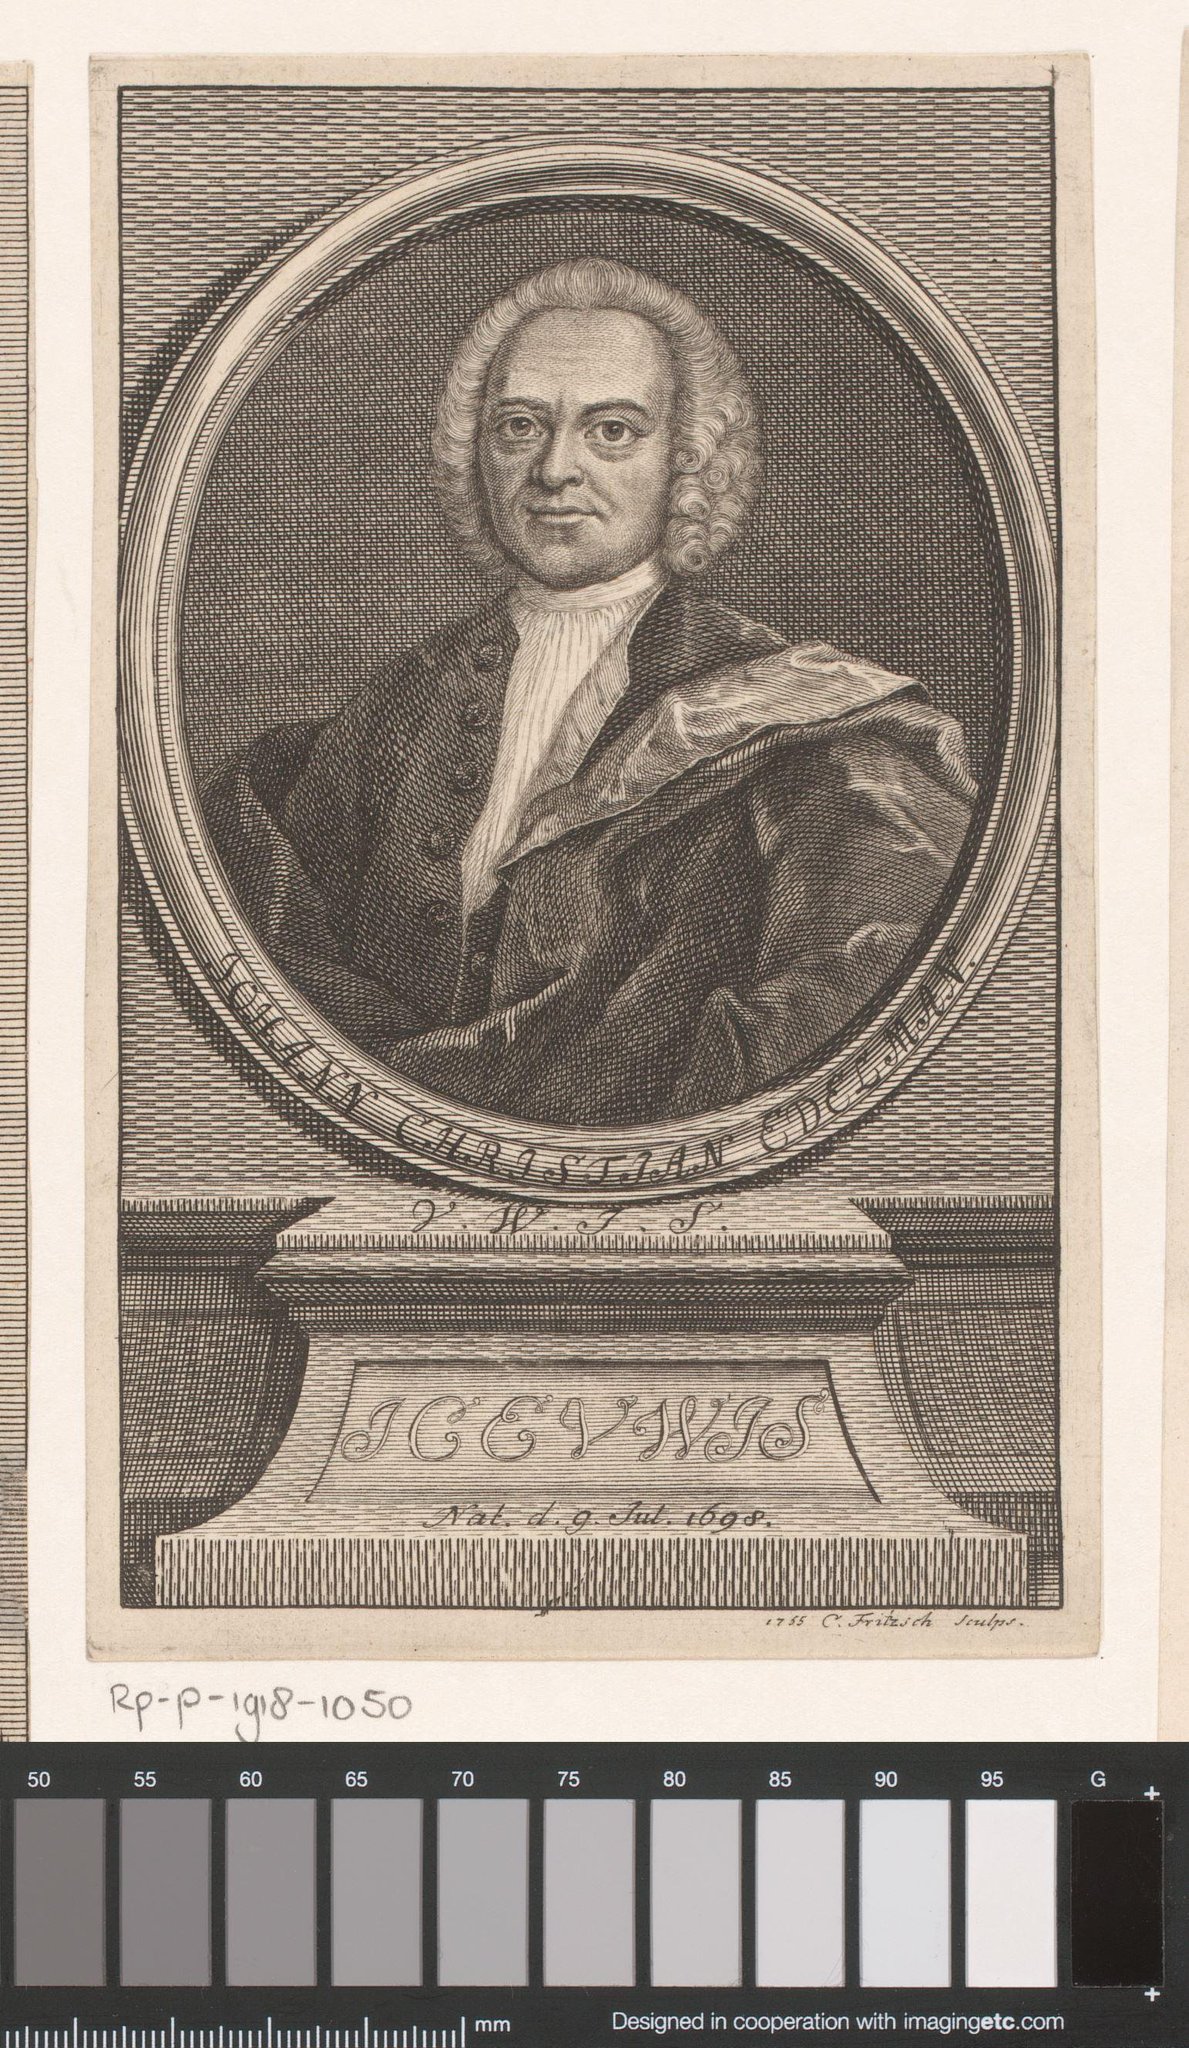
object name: print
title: Portret van J.Chr. Edelman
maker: christian fritzsch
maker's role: print maker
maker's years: 1695-1769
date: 1755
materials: paper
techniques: engraving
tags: berlin, theologian, historical persons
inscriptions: collector's mark: Lugt 2233